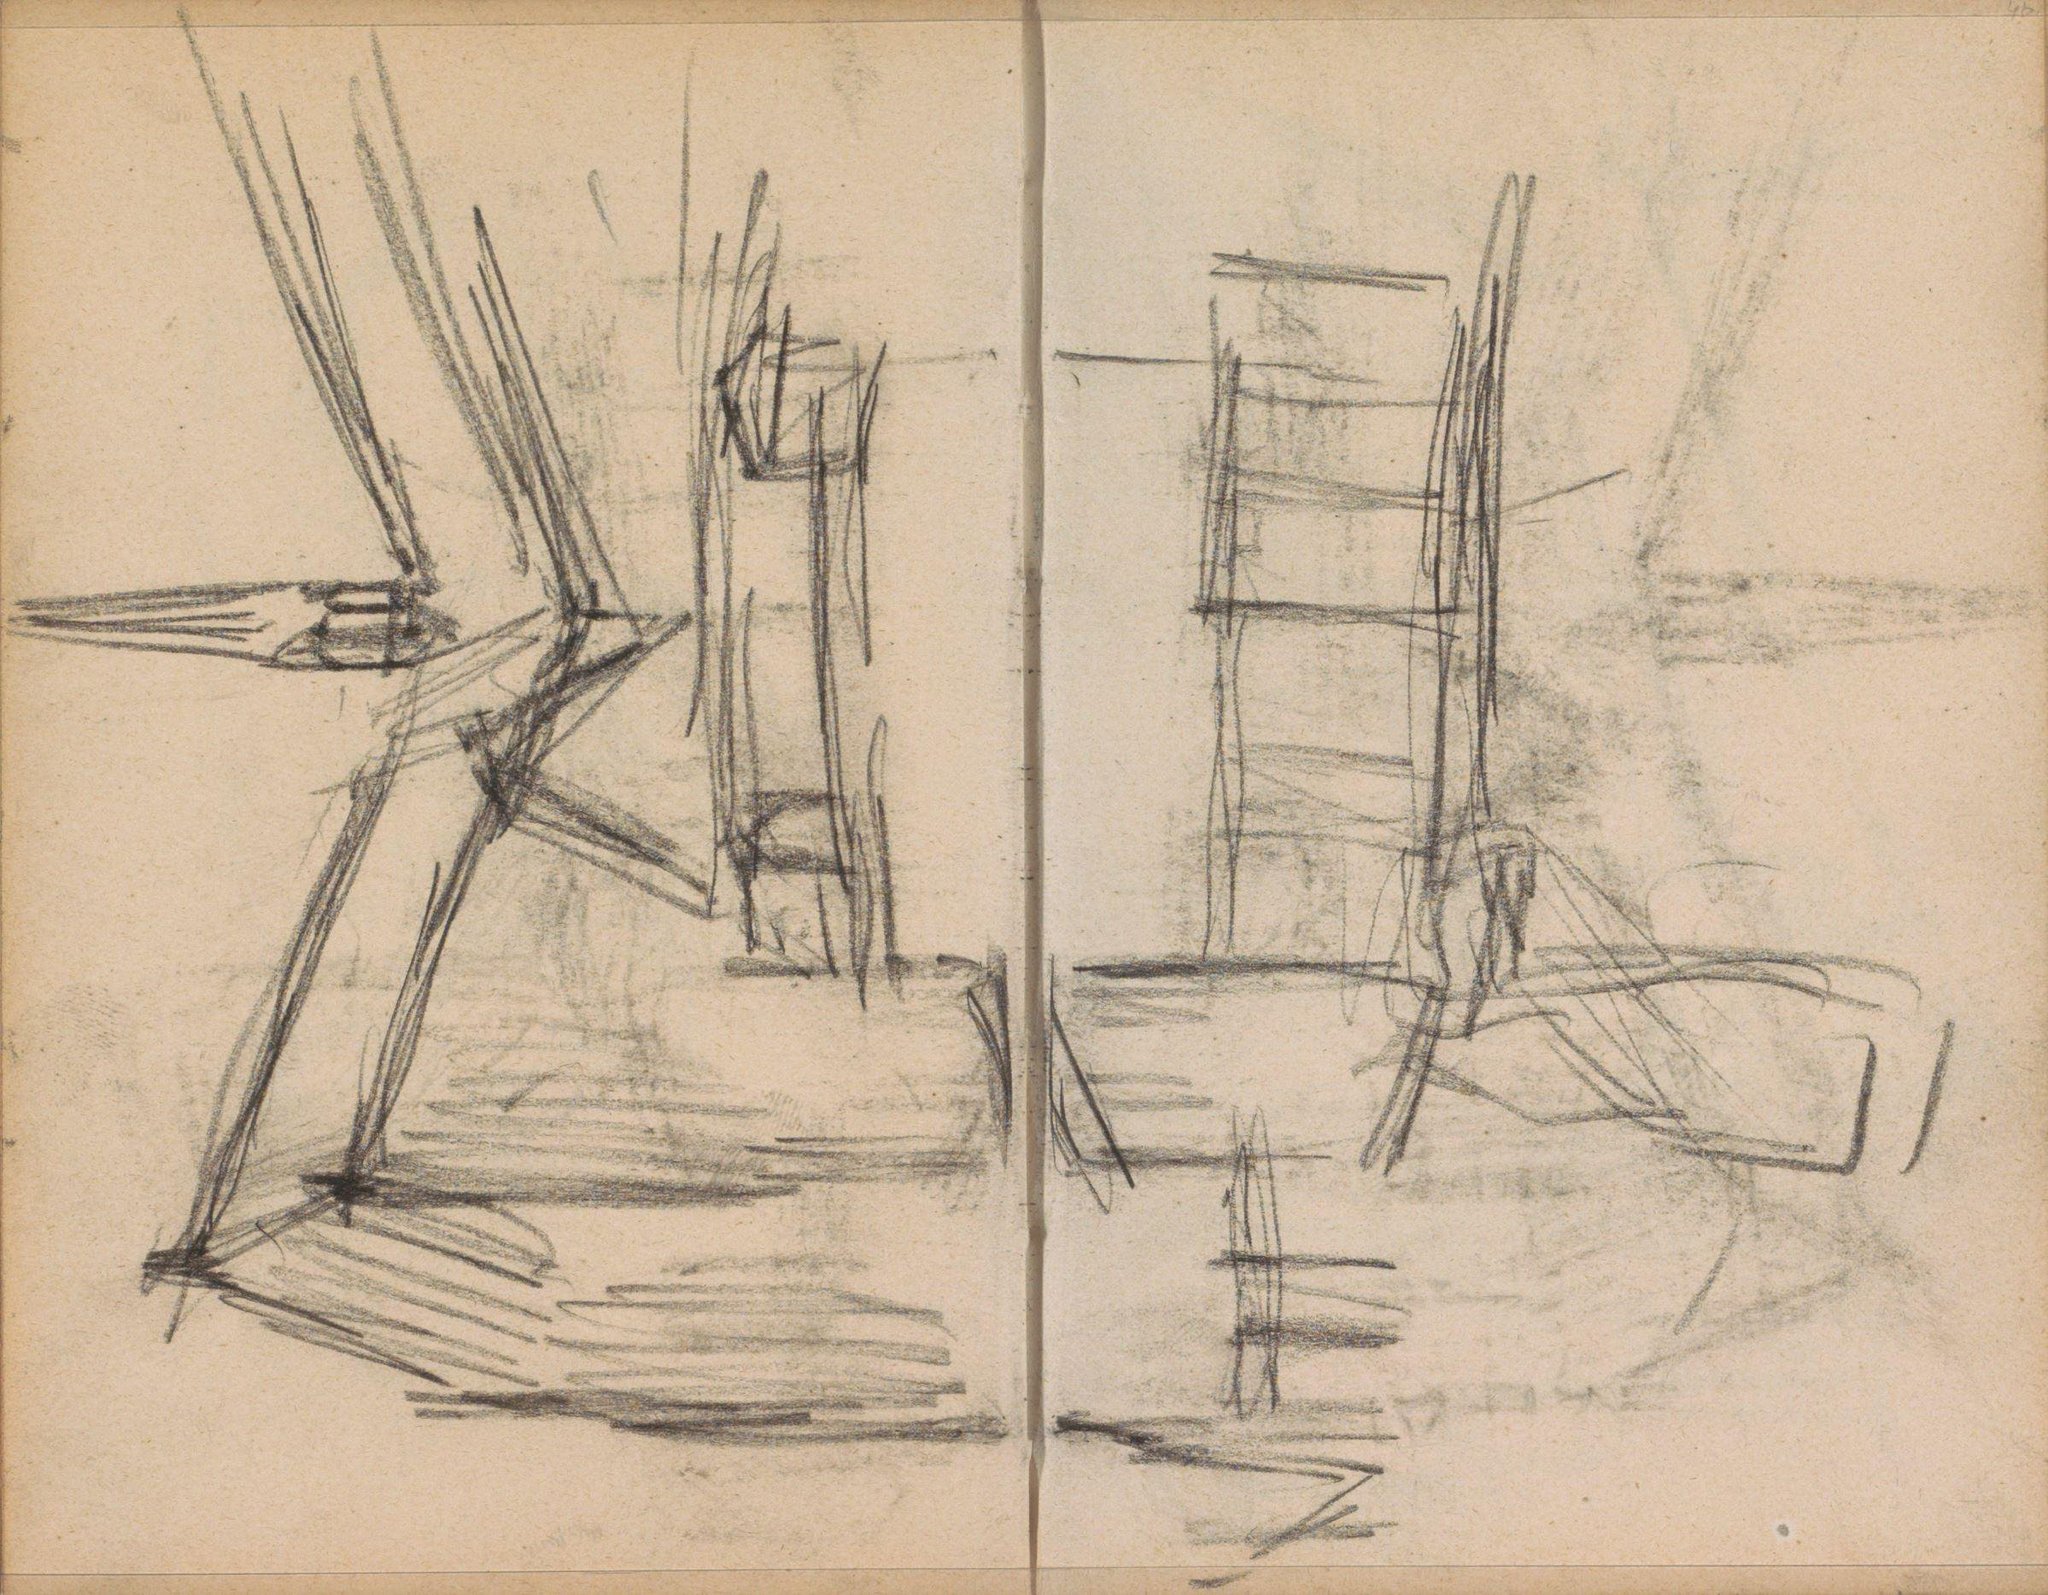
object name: sketchbook leaf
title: Gezicht op de Nieuwe Kerk te Amsterdam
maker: george hendrik breitner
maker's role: draughtsman, painter, print maker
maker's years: 1857-1923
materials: chalk, paper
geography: amsterdam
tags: church (exterior)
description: Pagina 45 en pagina 46 uit een schetsboek met 46 bladen.